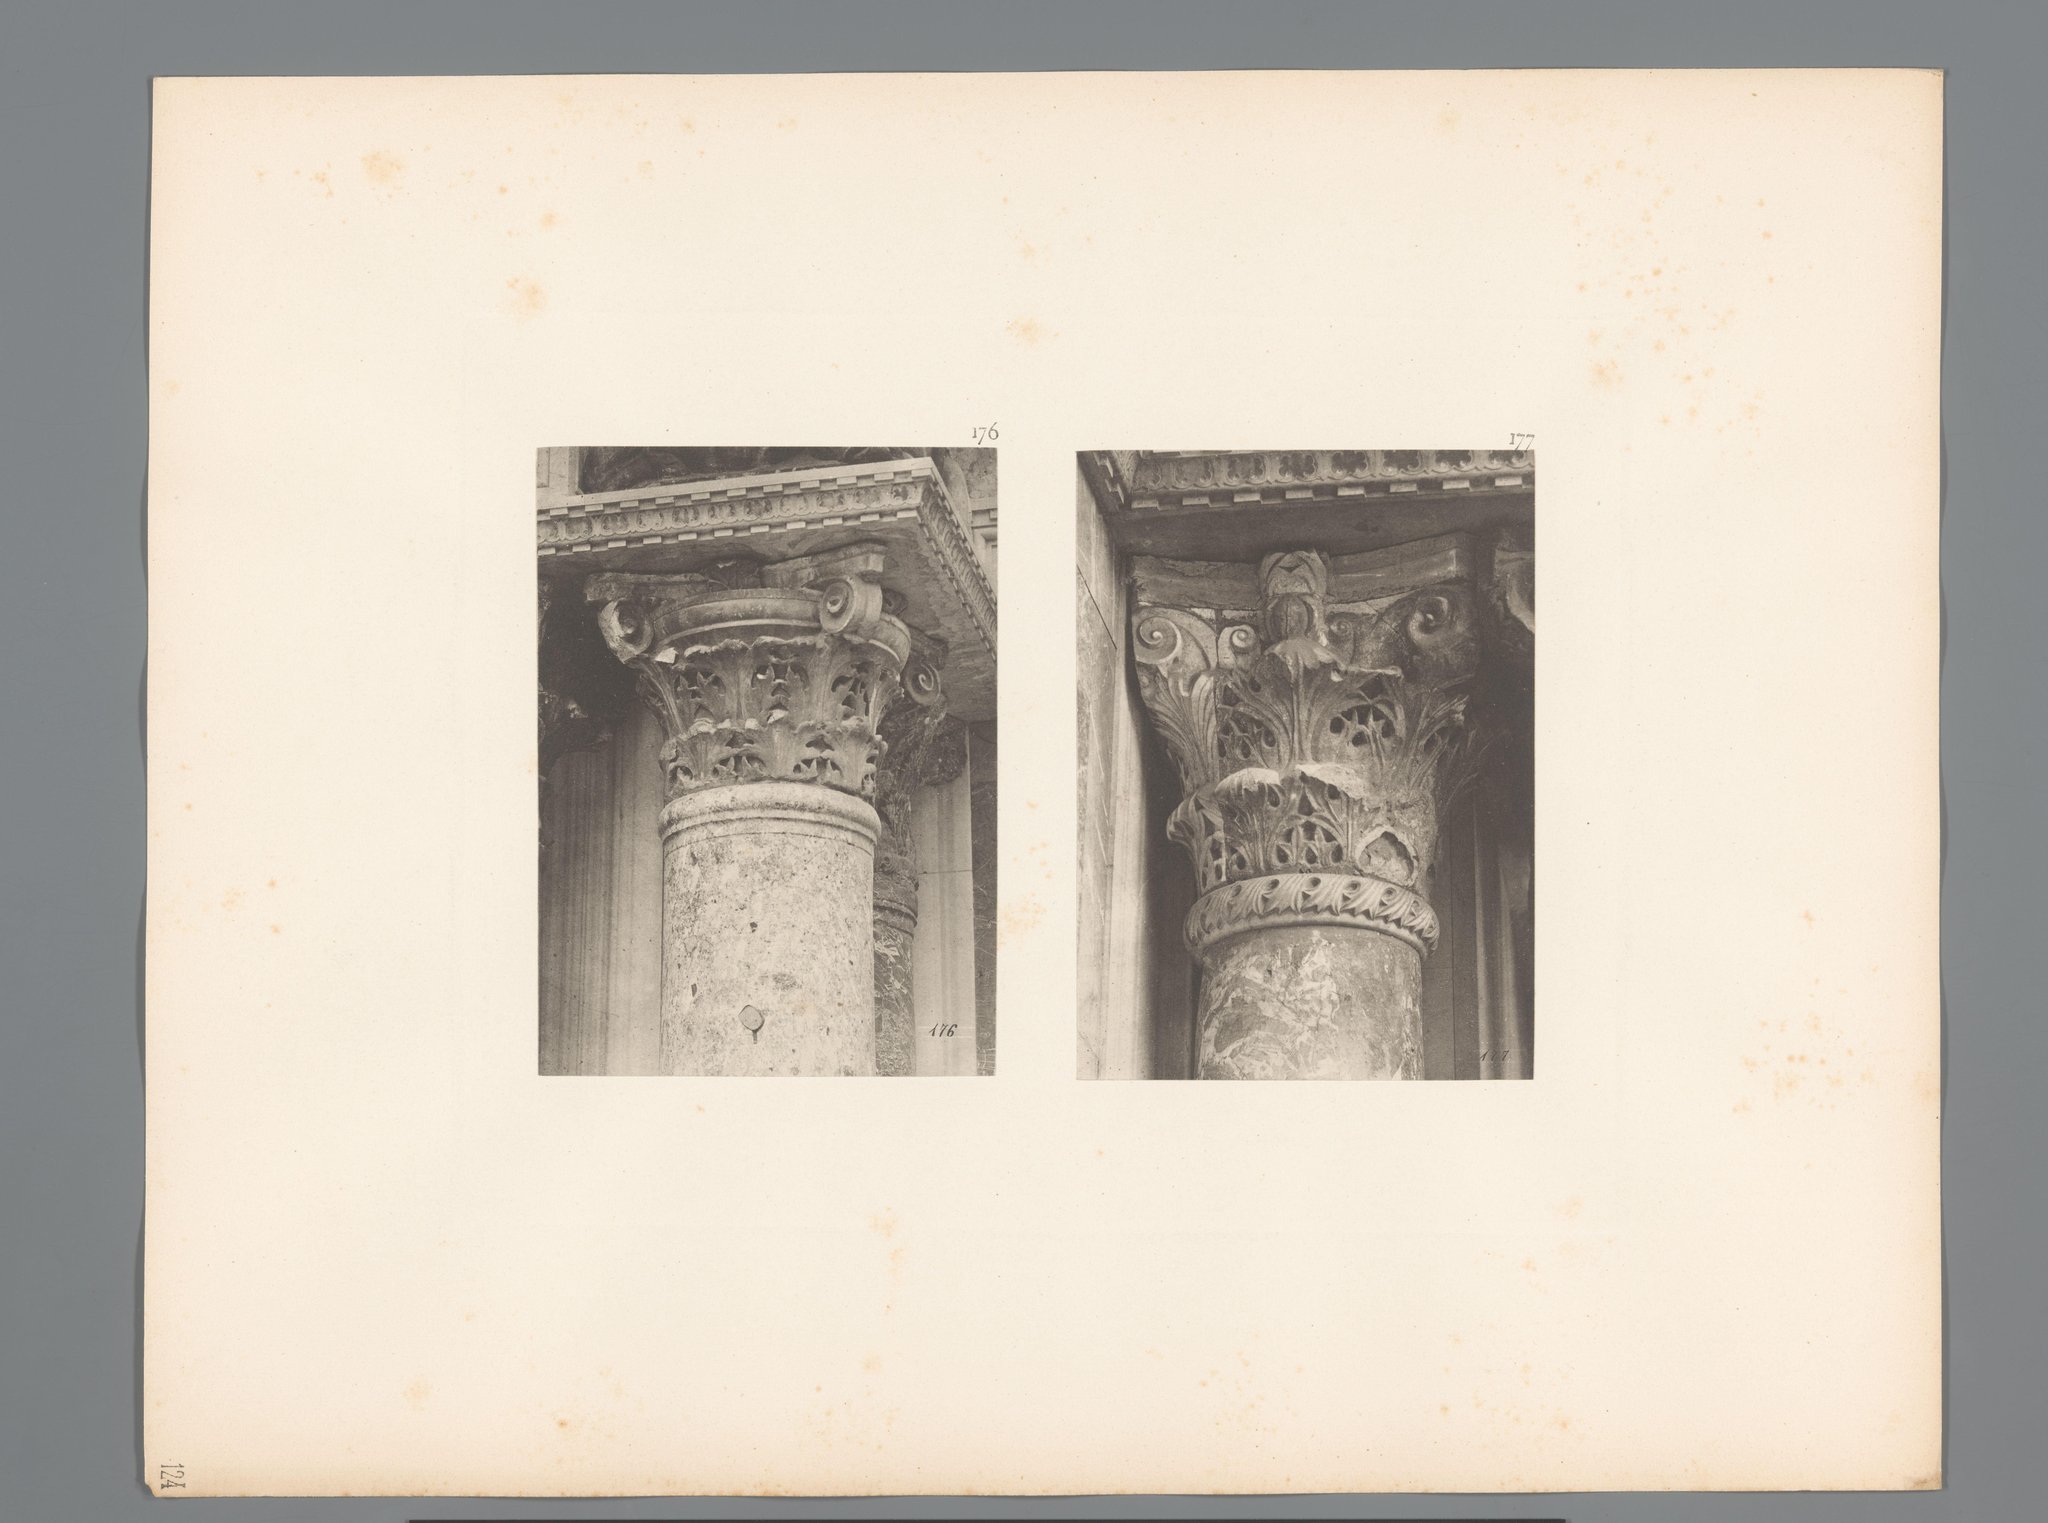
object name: photomechanical print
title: Twee afbeeldingen van Korinthische kapitelen van de San Marco in Venetië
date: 1879-1884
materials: paper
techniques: photograph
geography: venice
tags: capital (~ column, pillar) (+ classical art), church (exterior), corinthian order ~ architecture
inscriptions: number: ‘176’, number: ‘177’, number: ‘176’, number: ‘124’, number: ‘177’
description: Deze prenten maken deel uit van een omslag met 51 prenten op 29 bladen en 1 tekstblad.